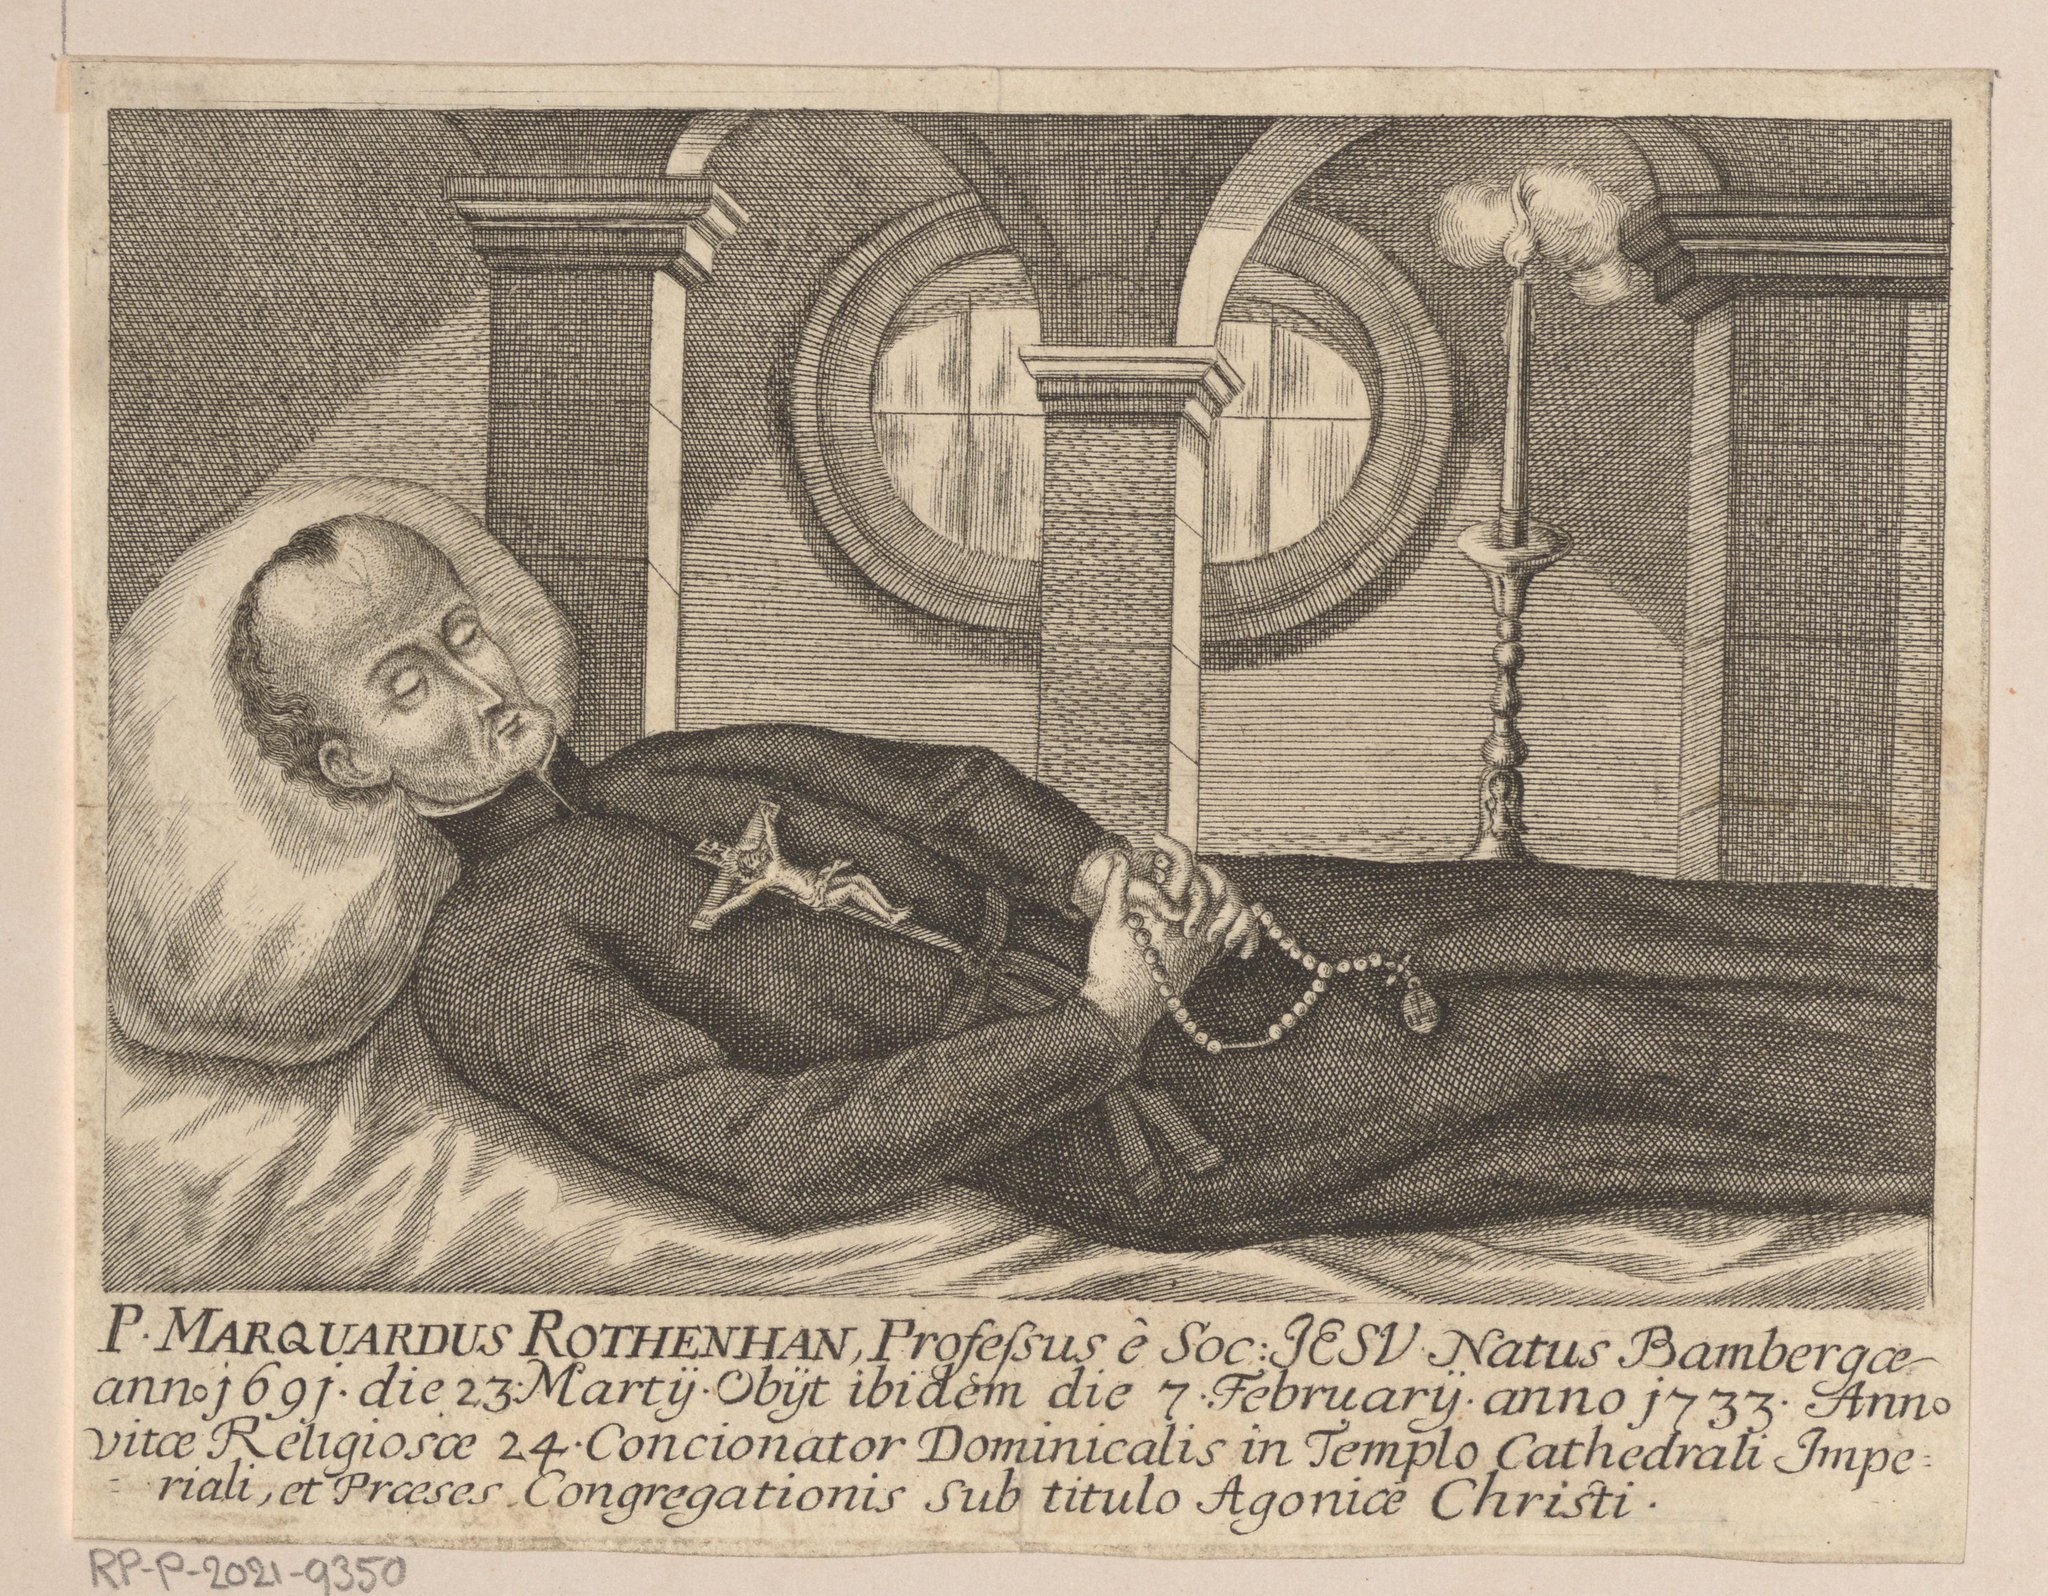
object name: print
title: Portret van Marquard von Rotenhan na zijn dood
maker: Anonymous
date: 1733-1799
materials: paper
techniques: engraving, etching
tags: historical persons, candle